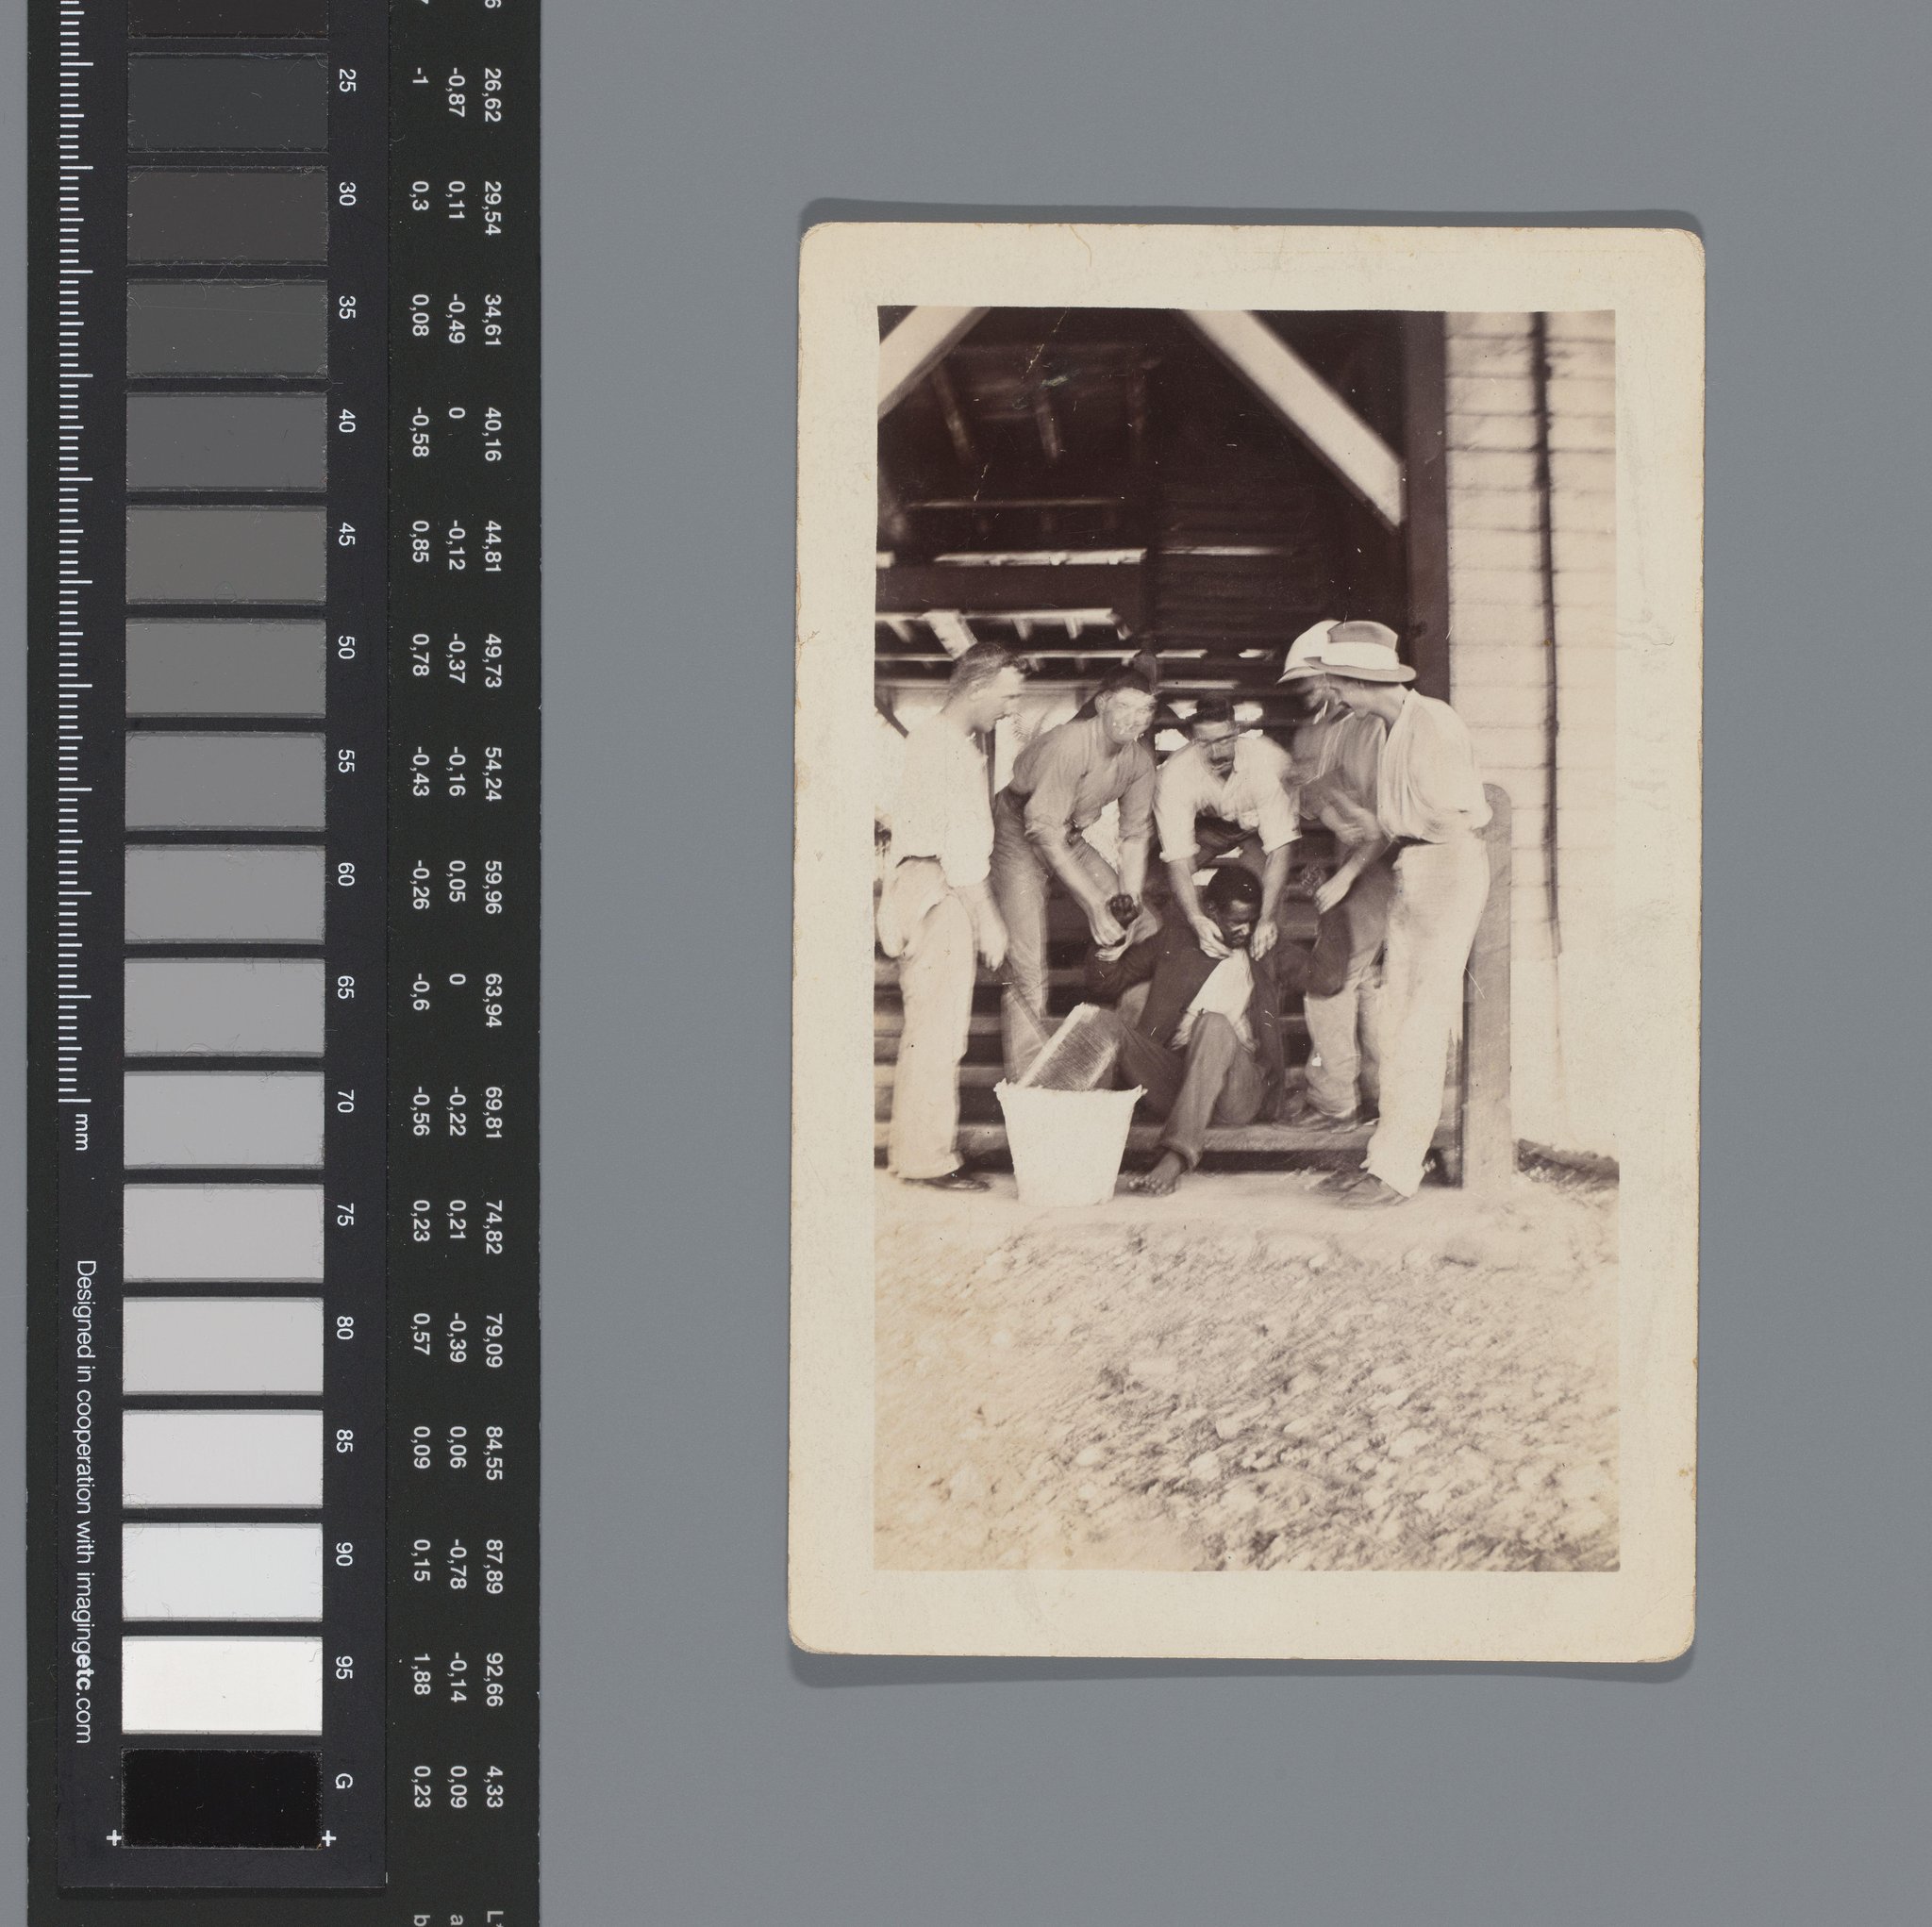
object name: ansichtkaart, prentbriefkaart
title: Vijf witte mannen die een zwarte man (lijken te) molesteren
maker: Anonymous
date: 1920-1940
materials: photographic support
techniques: gelatin silver print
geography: united states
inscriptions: inscription: ‘POST CARD // CORRESPONDANCE HERE / NAME AND ADDRESS HERE // SOLIO / SOLIO / SOLIO / SOLIO // PLACE / STAMP / HERE’’